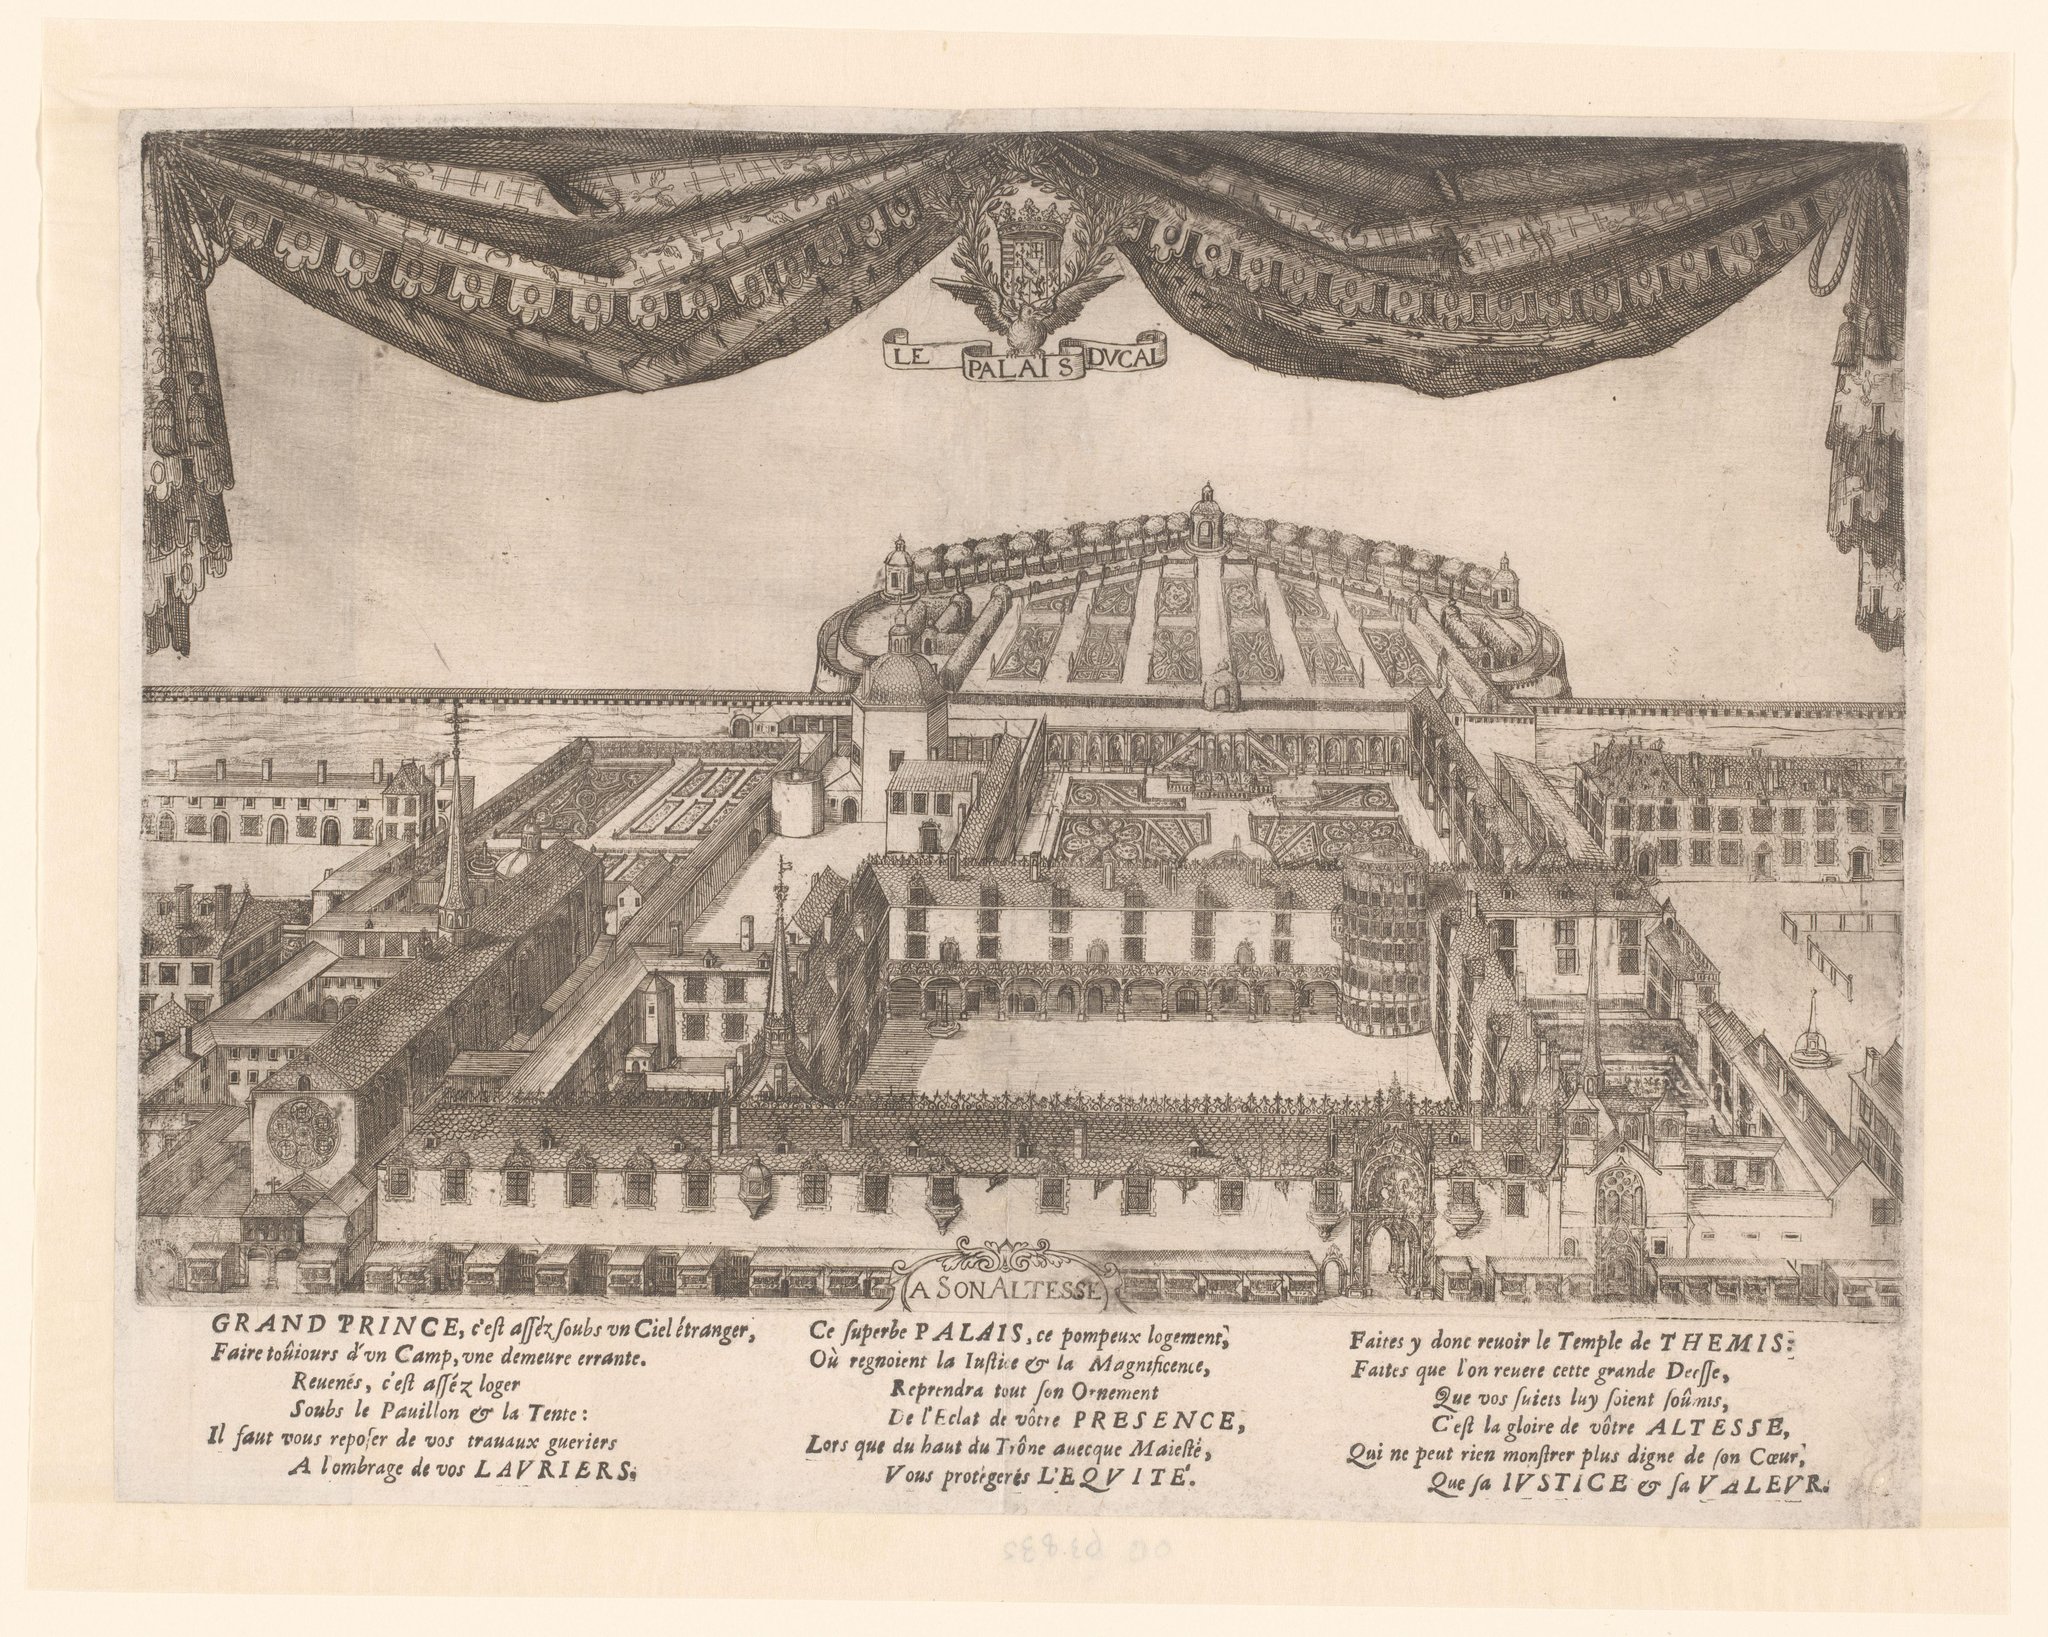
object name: book illustration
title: Gezicht op het hertogelijk paleis te Nancy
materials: paper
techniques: etching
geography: nancy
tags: city-view in general; 'veduta', palace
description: Prent uit: Bardin, Philippe. Le triomphe de Son Altesse Charles IIII, duc de Lorraine (...). Nancy: 1664.